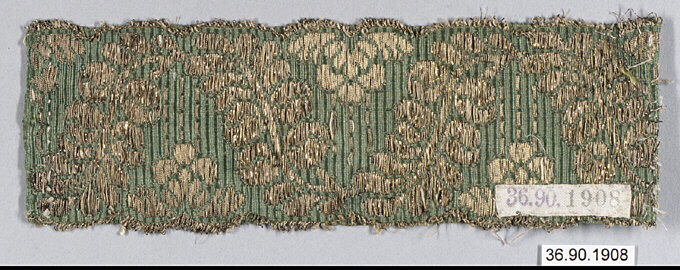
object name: piece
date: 1767-1833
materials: metal thread, silk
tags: flowers,leaves